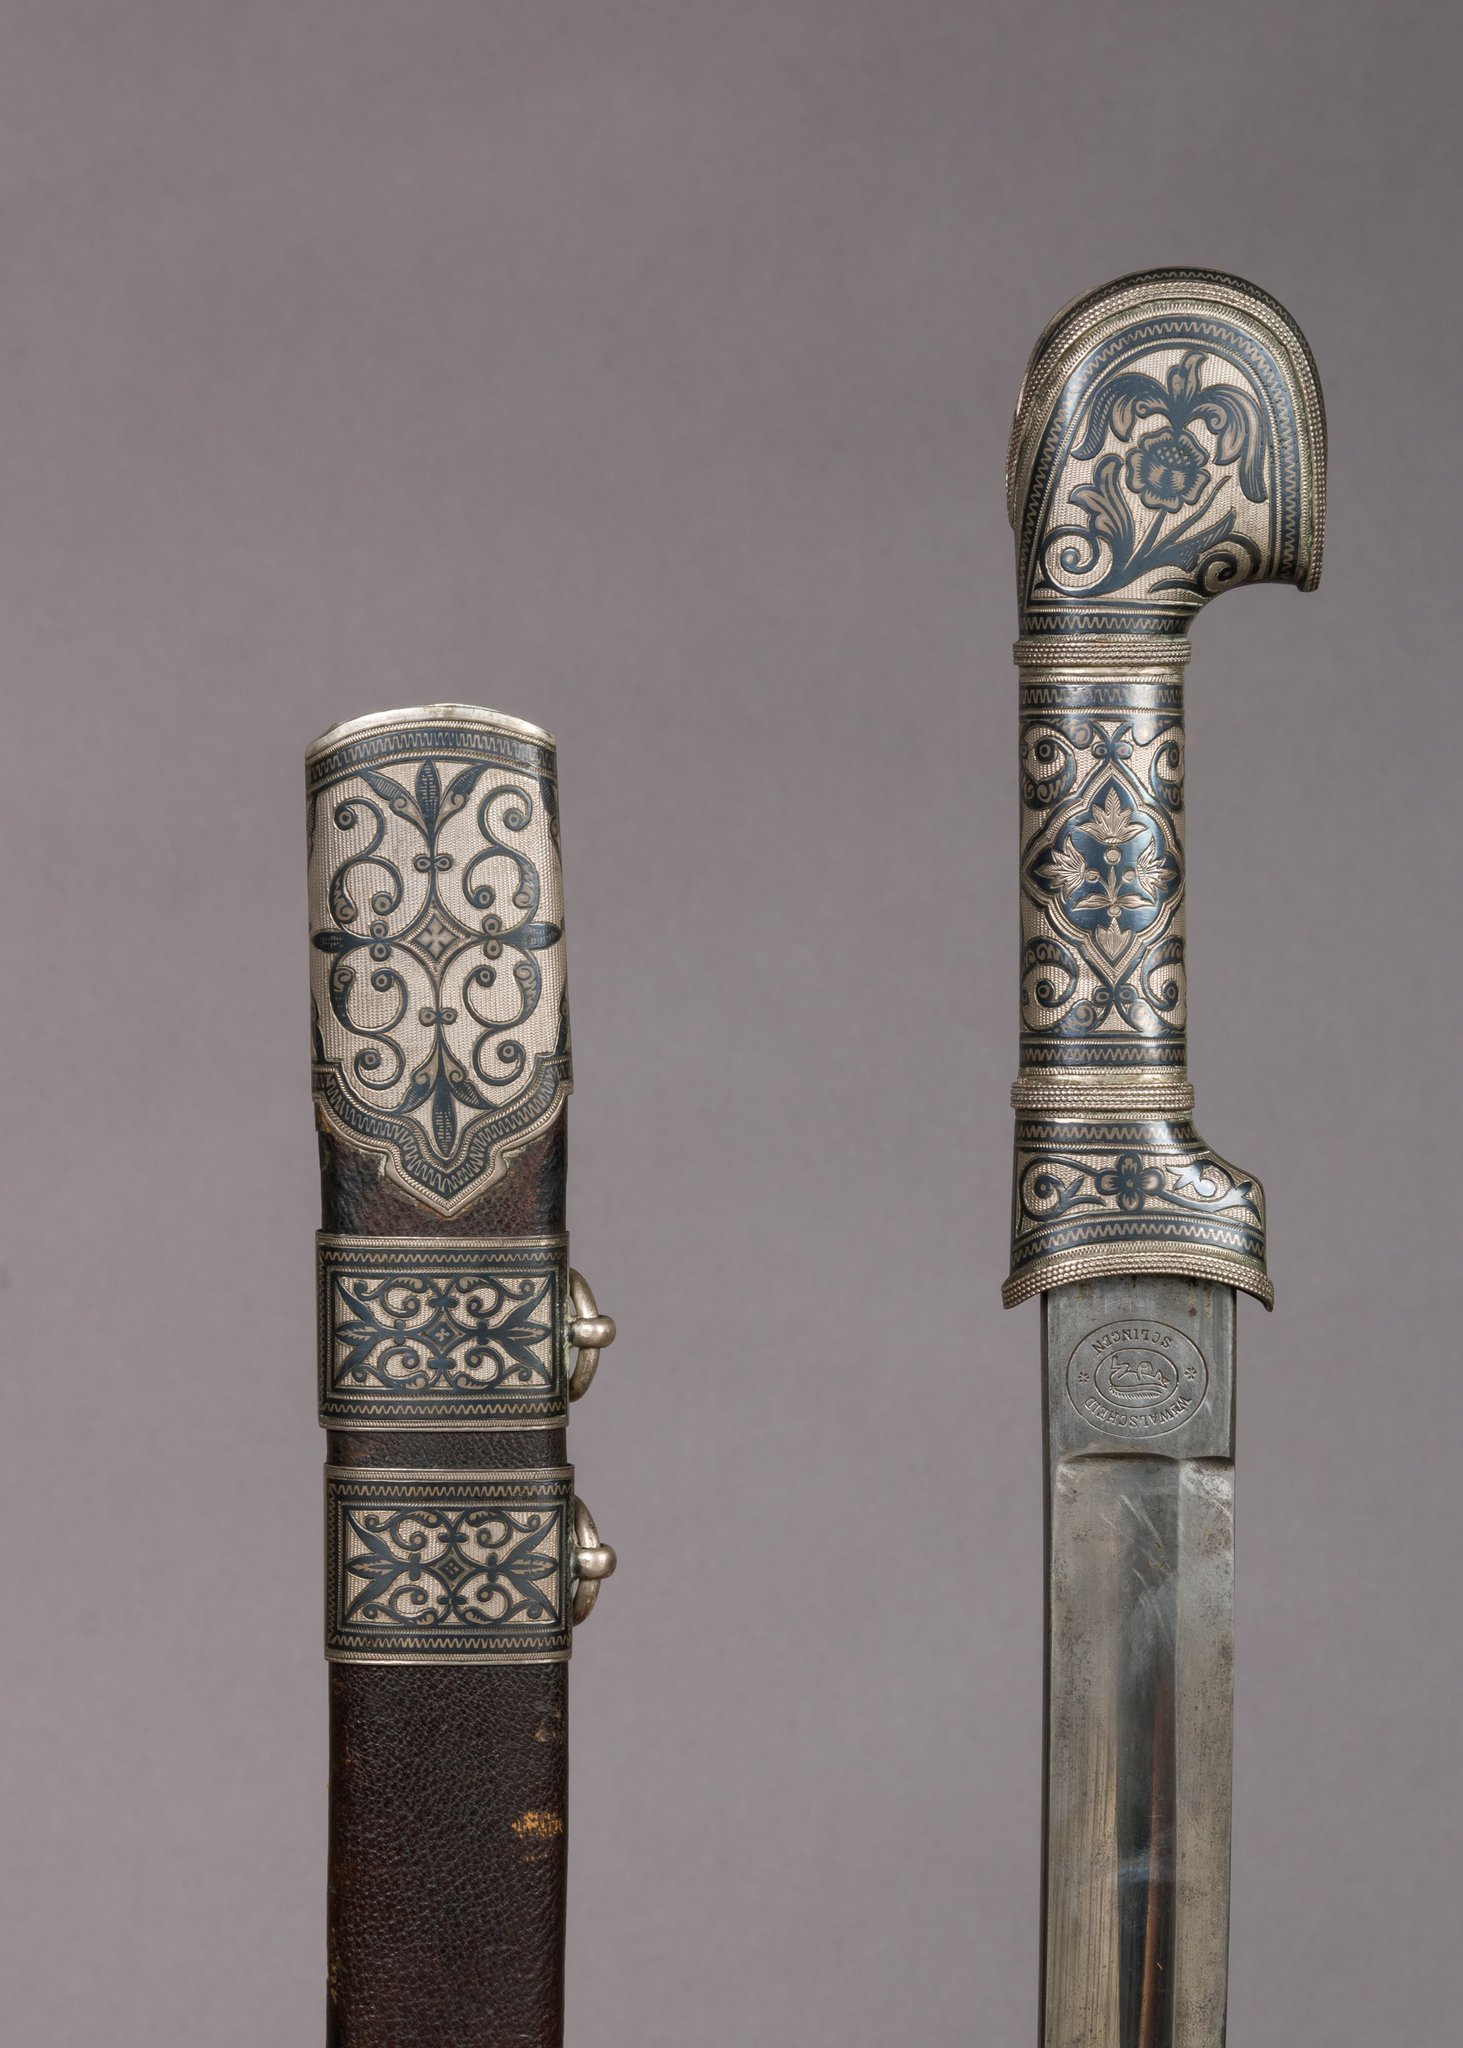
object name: sword with scabbard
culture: caucasian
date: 1875-1900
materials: leather, silver, steel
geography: caucasus